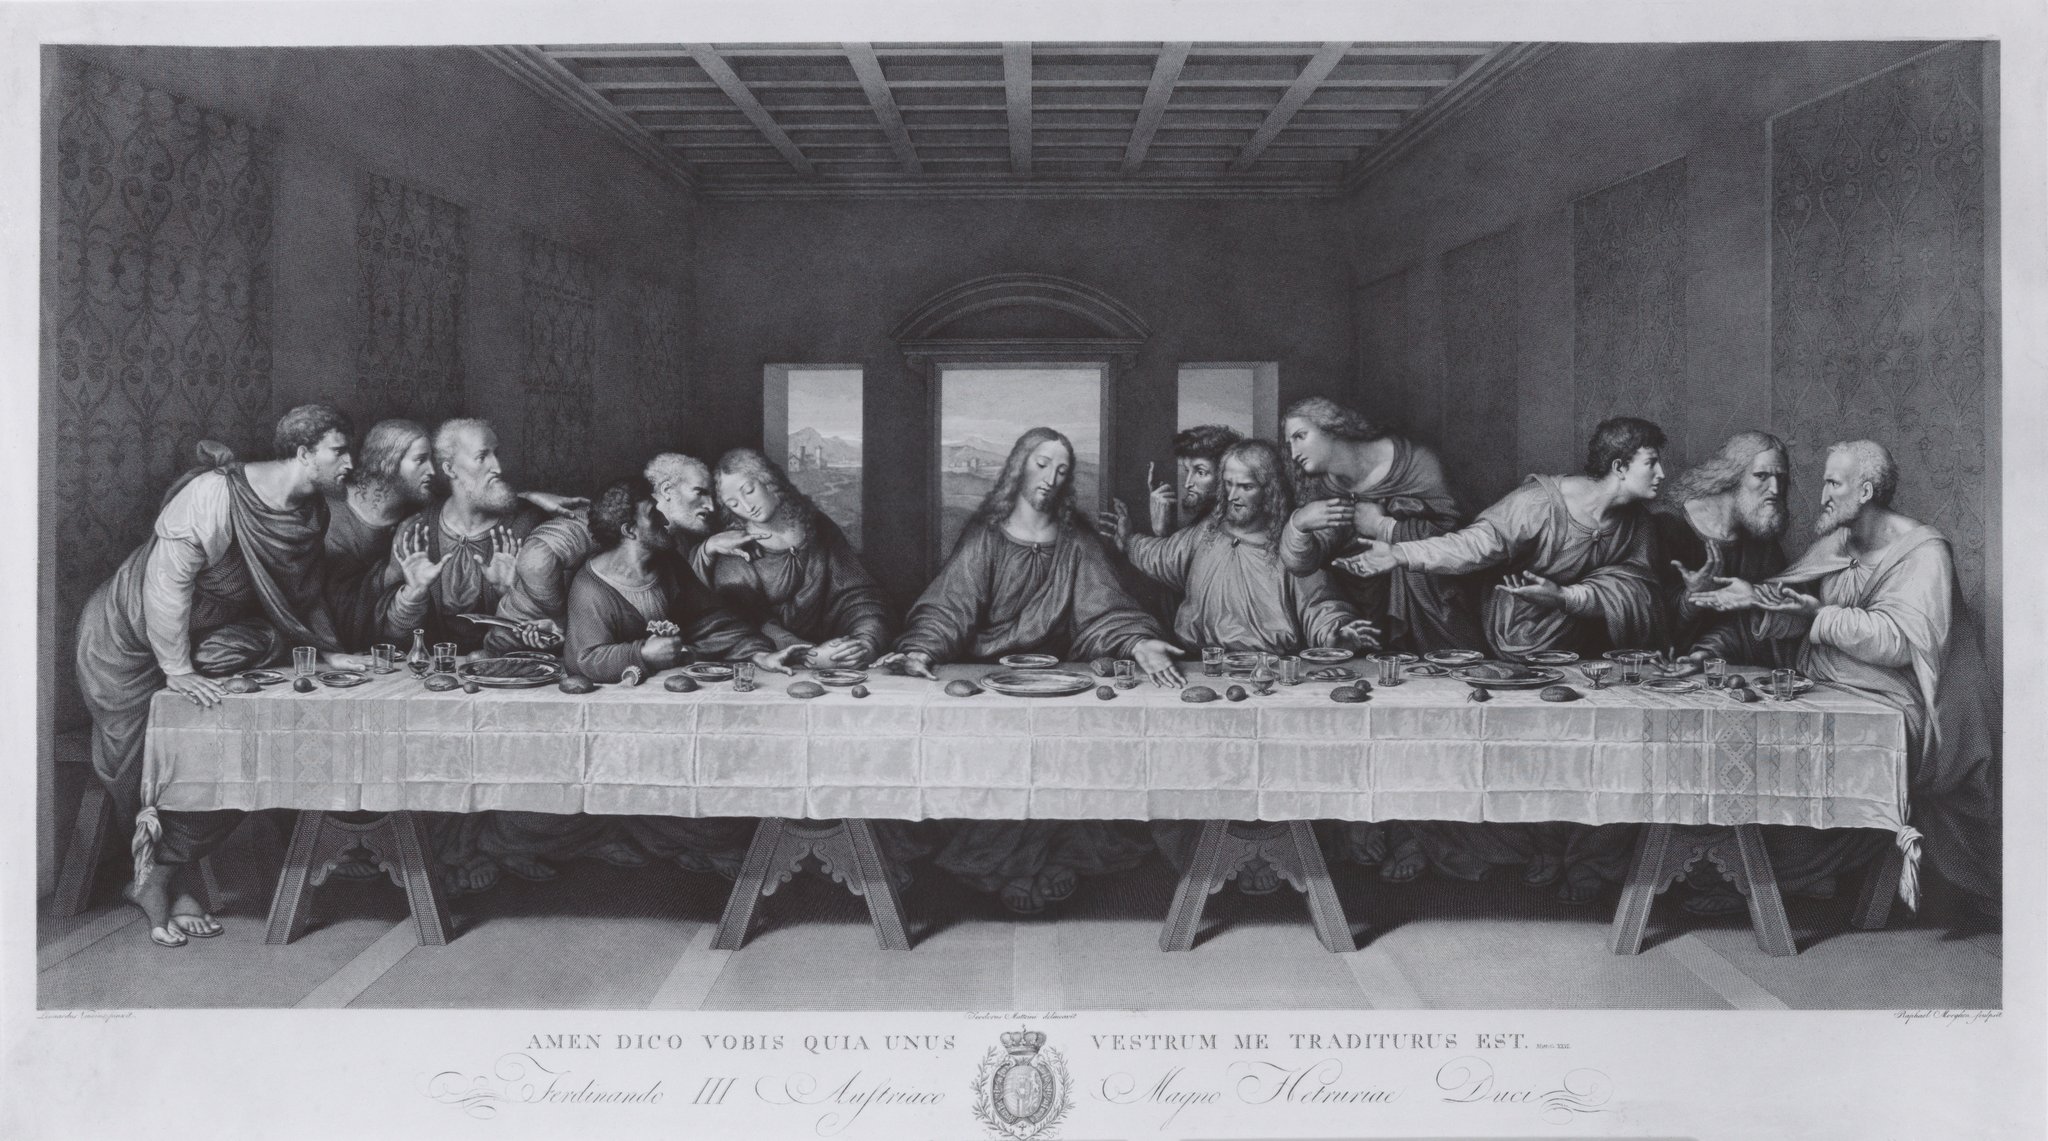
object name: print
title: The Last Supper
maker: raphael morghen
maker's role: artist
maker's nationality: italian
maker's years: 1758-1833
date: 1800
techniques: engraving